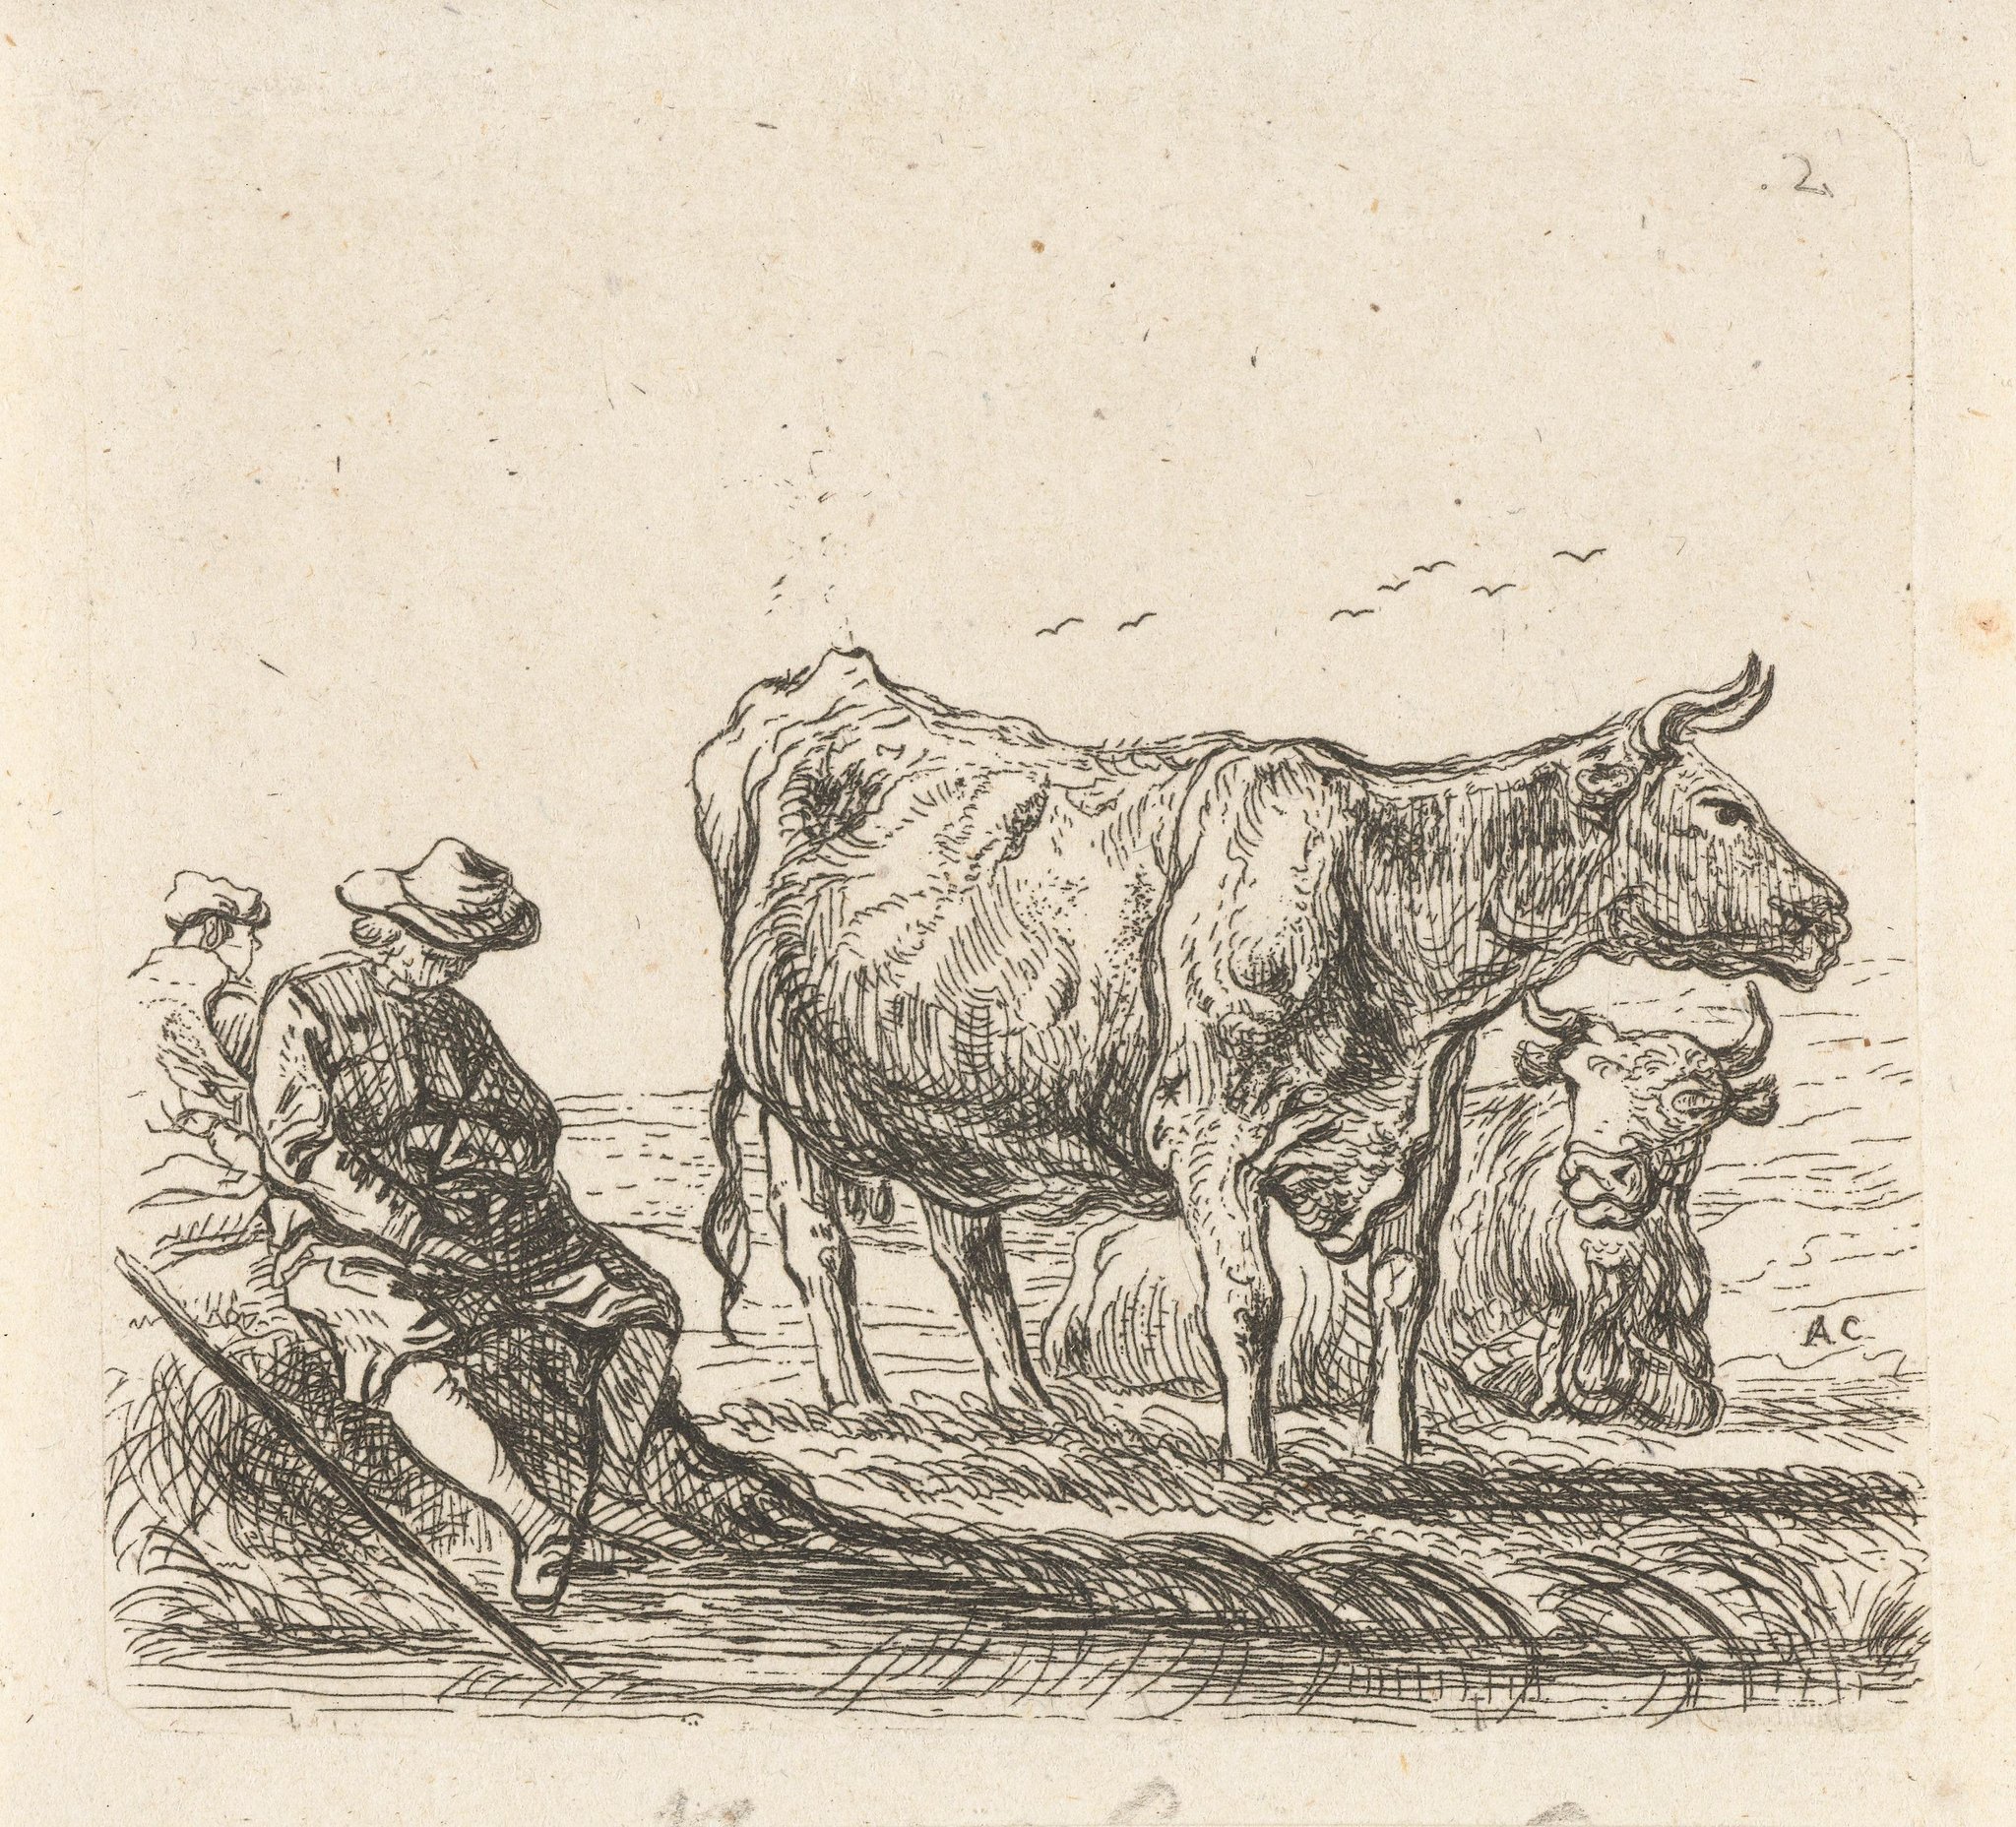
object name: print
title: Twee koeien met twee herders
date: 1814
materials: paper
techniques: etching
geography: netherlands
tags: cow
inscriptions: collector's mark: Lugt 2228